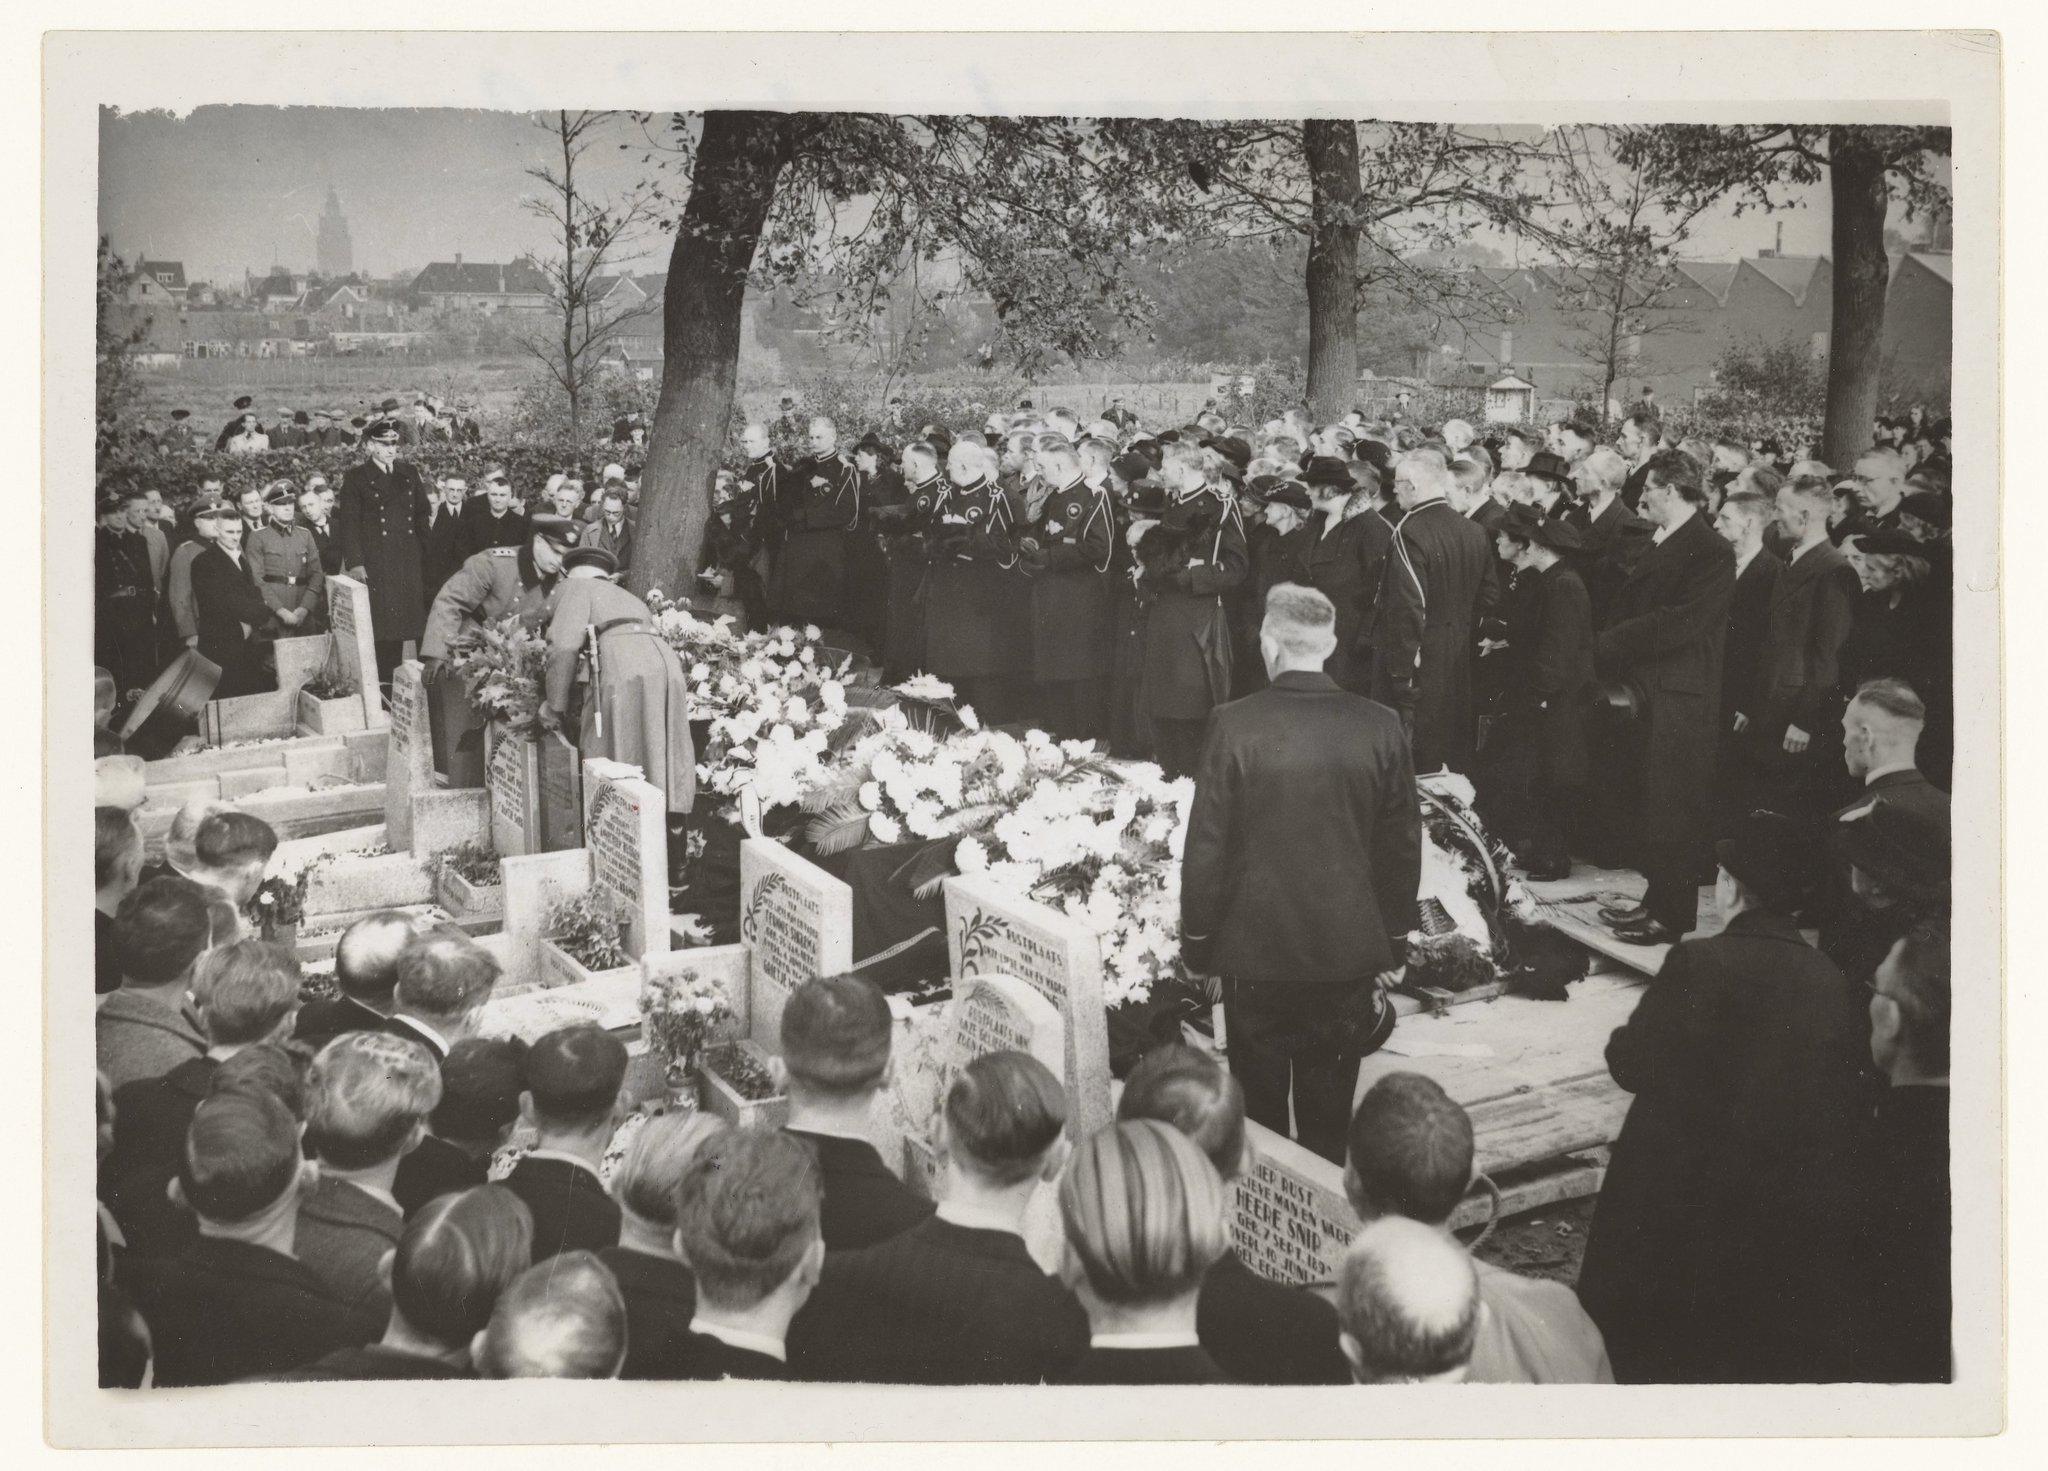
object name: photograph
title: Begrafenis Zuiderbegraafplaats te Groningen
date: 1940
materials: photographic support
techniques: gelatin silver print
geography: netherlands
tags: public funeral, netherlands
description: Op woensdag 16 oktober 1940 vond in Groningen een ernstig busongeluk plaats op de treinovergang bij Ranum tussen Winsum en Baflo. Daarbij kwamen dertien werkverschaffingsarbeiders om het leven, die onderweg waren naar de inpolderingswerkzaamheden bij De Slikken. Negen van de dertien slachtoffers werden onder grote belangstelling op zaterdag 19 oktober 1940 gezamenlijk begraven op de Groninger Zuiderbegraafplaats. Vertegenwoordiger van de rijkscommissaris voor Groningen dr. C. Conring sprak namens de Duitse autoriteiten. Terwijl door officieren van de Duitse weermacht een krans werd gelegd. Onder de aanwezigen waren ook de burgemeester van Groningen mr. P.W.J.H. Cort van der Linden en de commissaris van de provincie Groningen mr. J. Linthorst Homan.